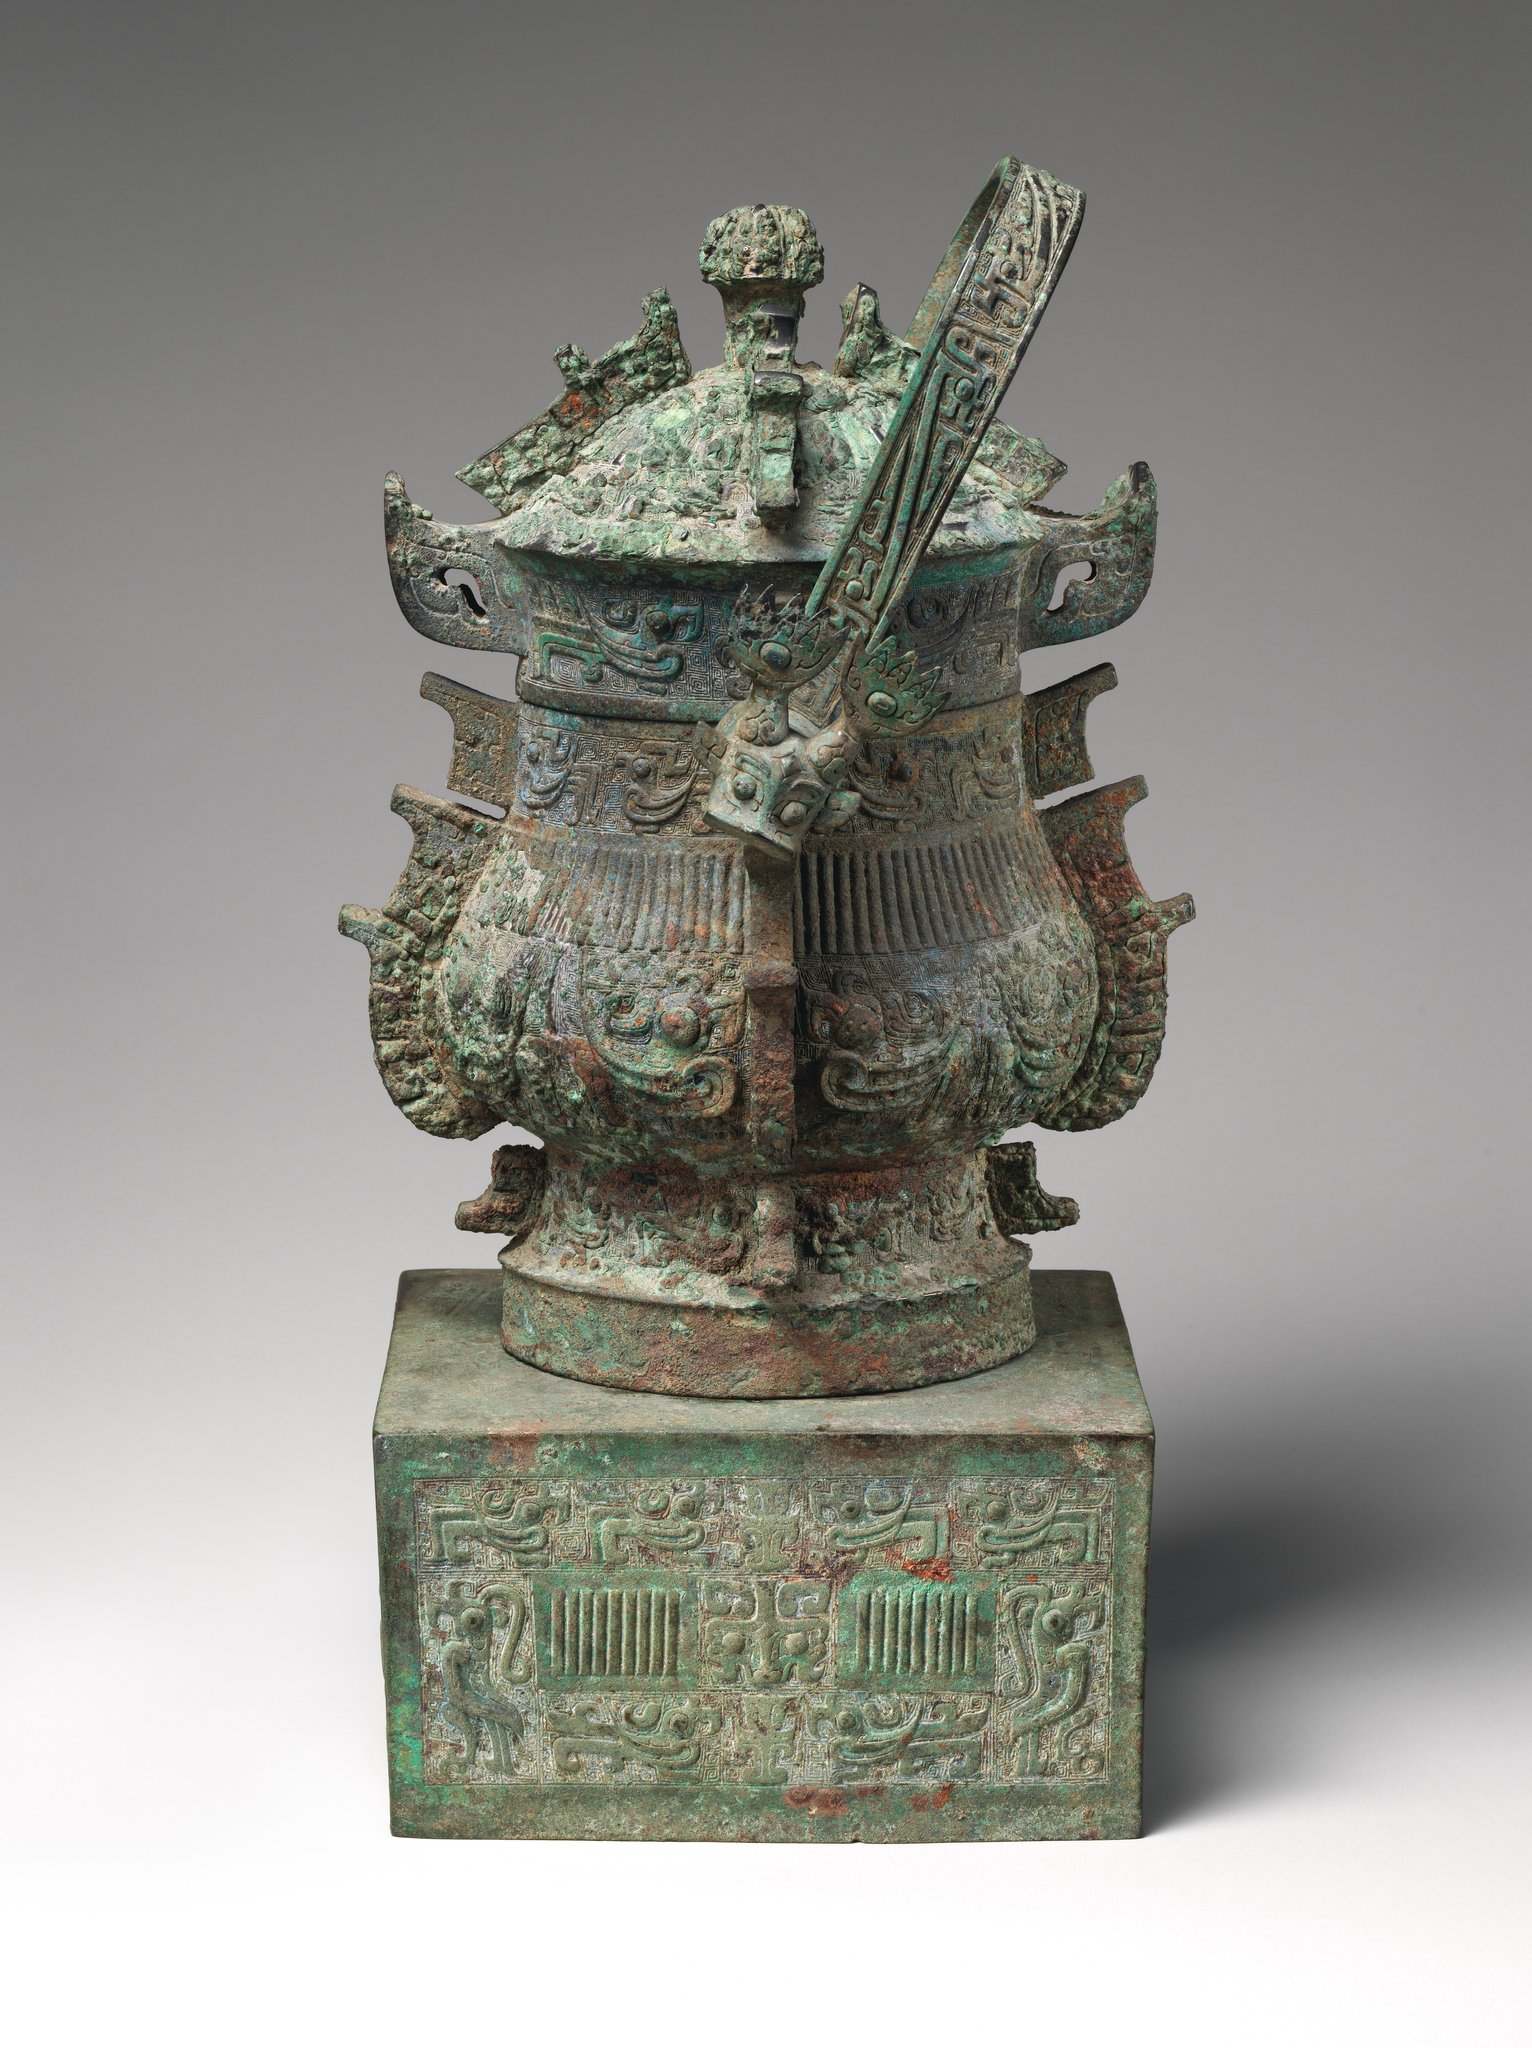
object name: wine container and pedestal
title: Ritual Wine Container (Yu) with Lid and Pedestal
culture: chinese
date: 1034-1001 BCE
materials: bronze